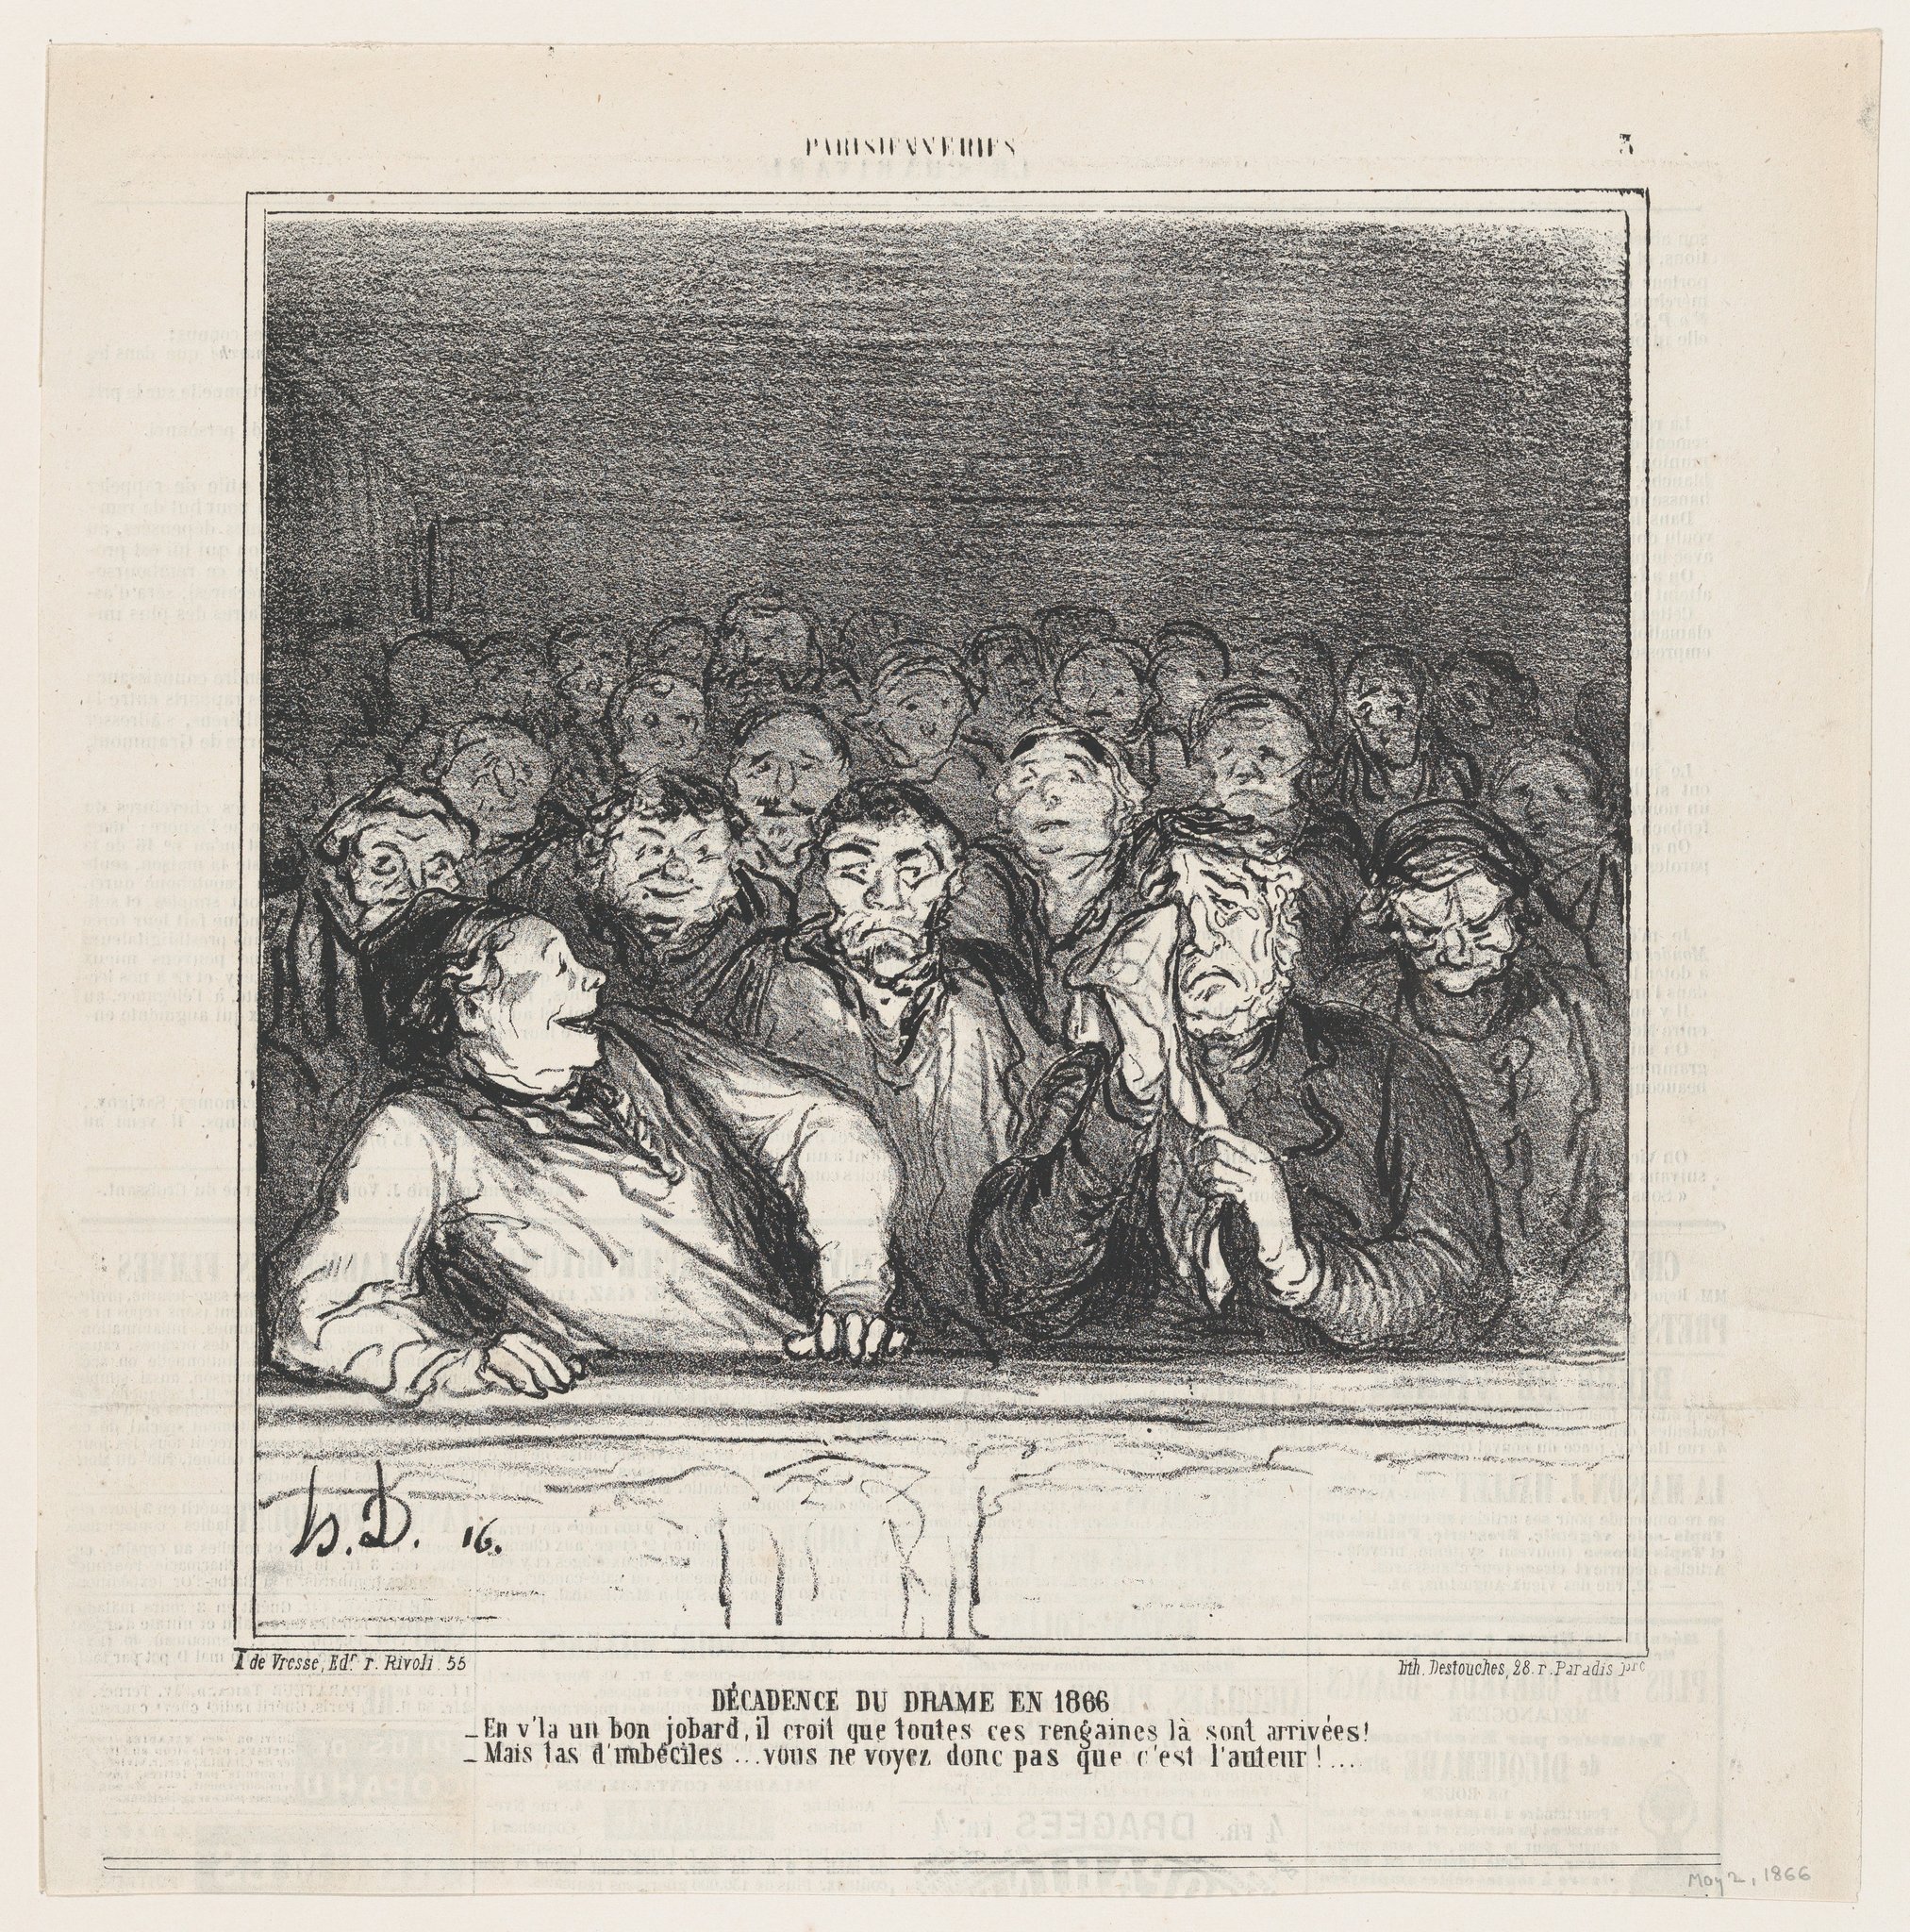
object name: print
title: The decline of the drama in 1866, from 'Parisian habits,' published in Le Charivari, May 2, 1866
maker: honoré daumier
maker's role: artist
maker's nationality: french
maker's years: 1808-1879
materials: paper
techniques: lithograph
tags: satire,theatre,sadness,spectators